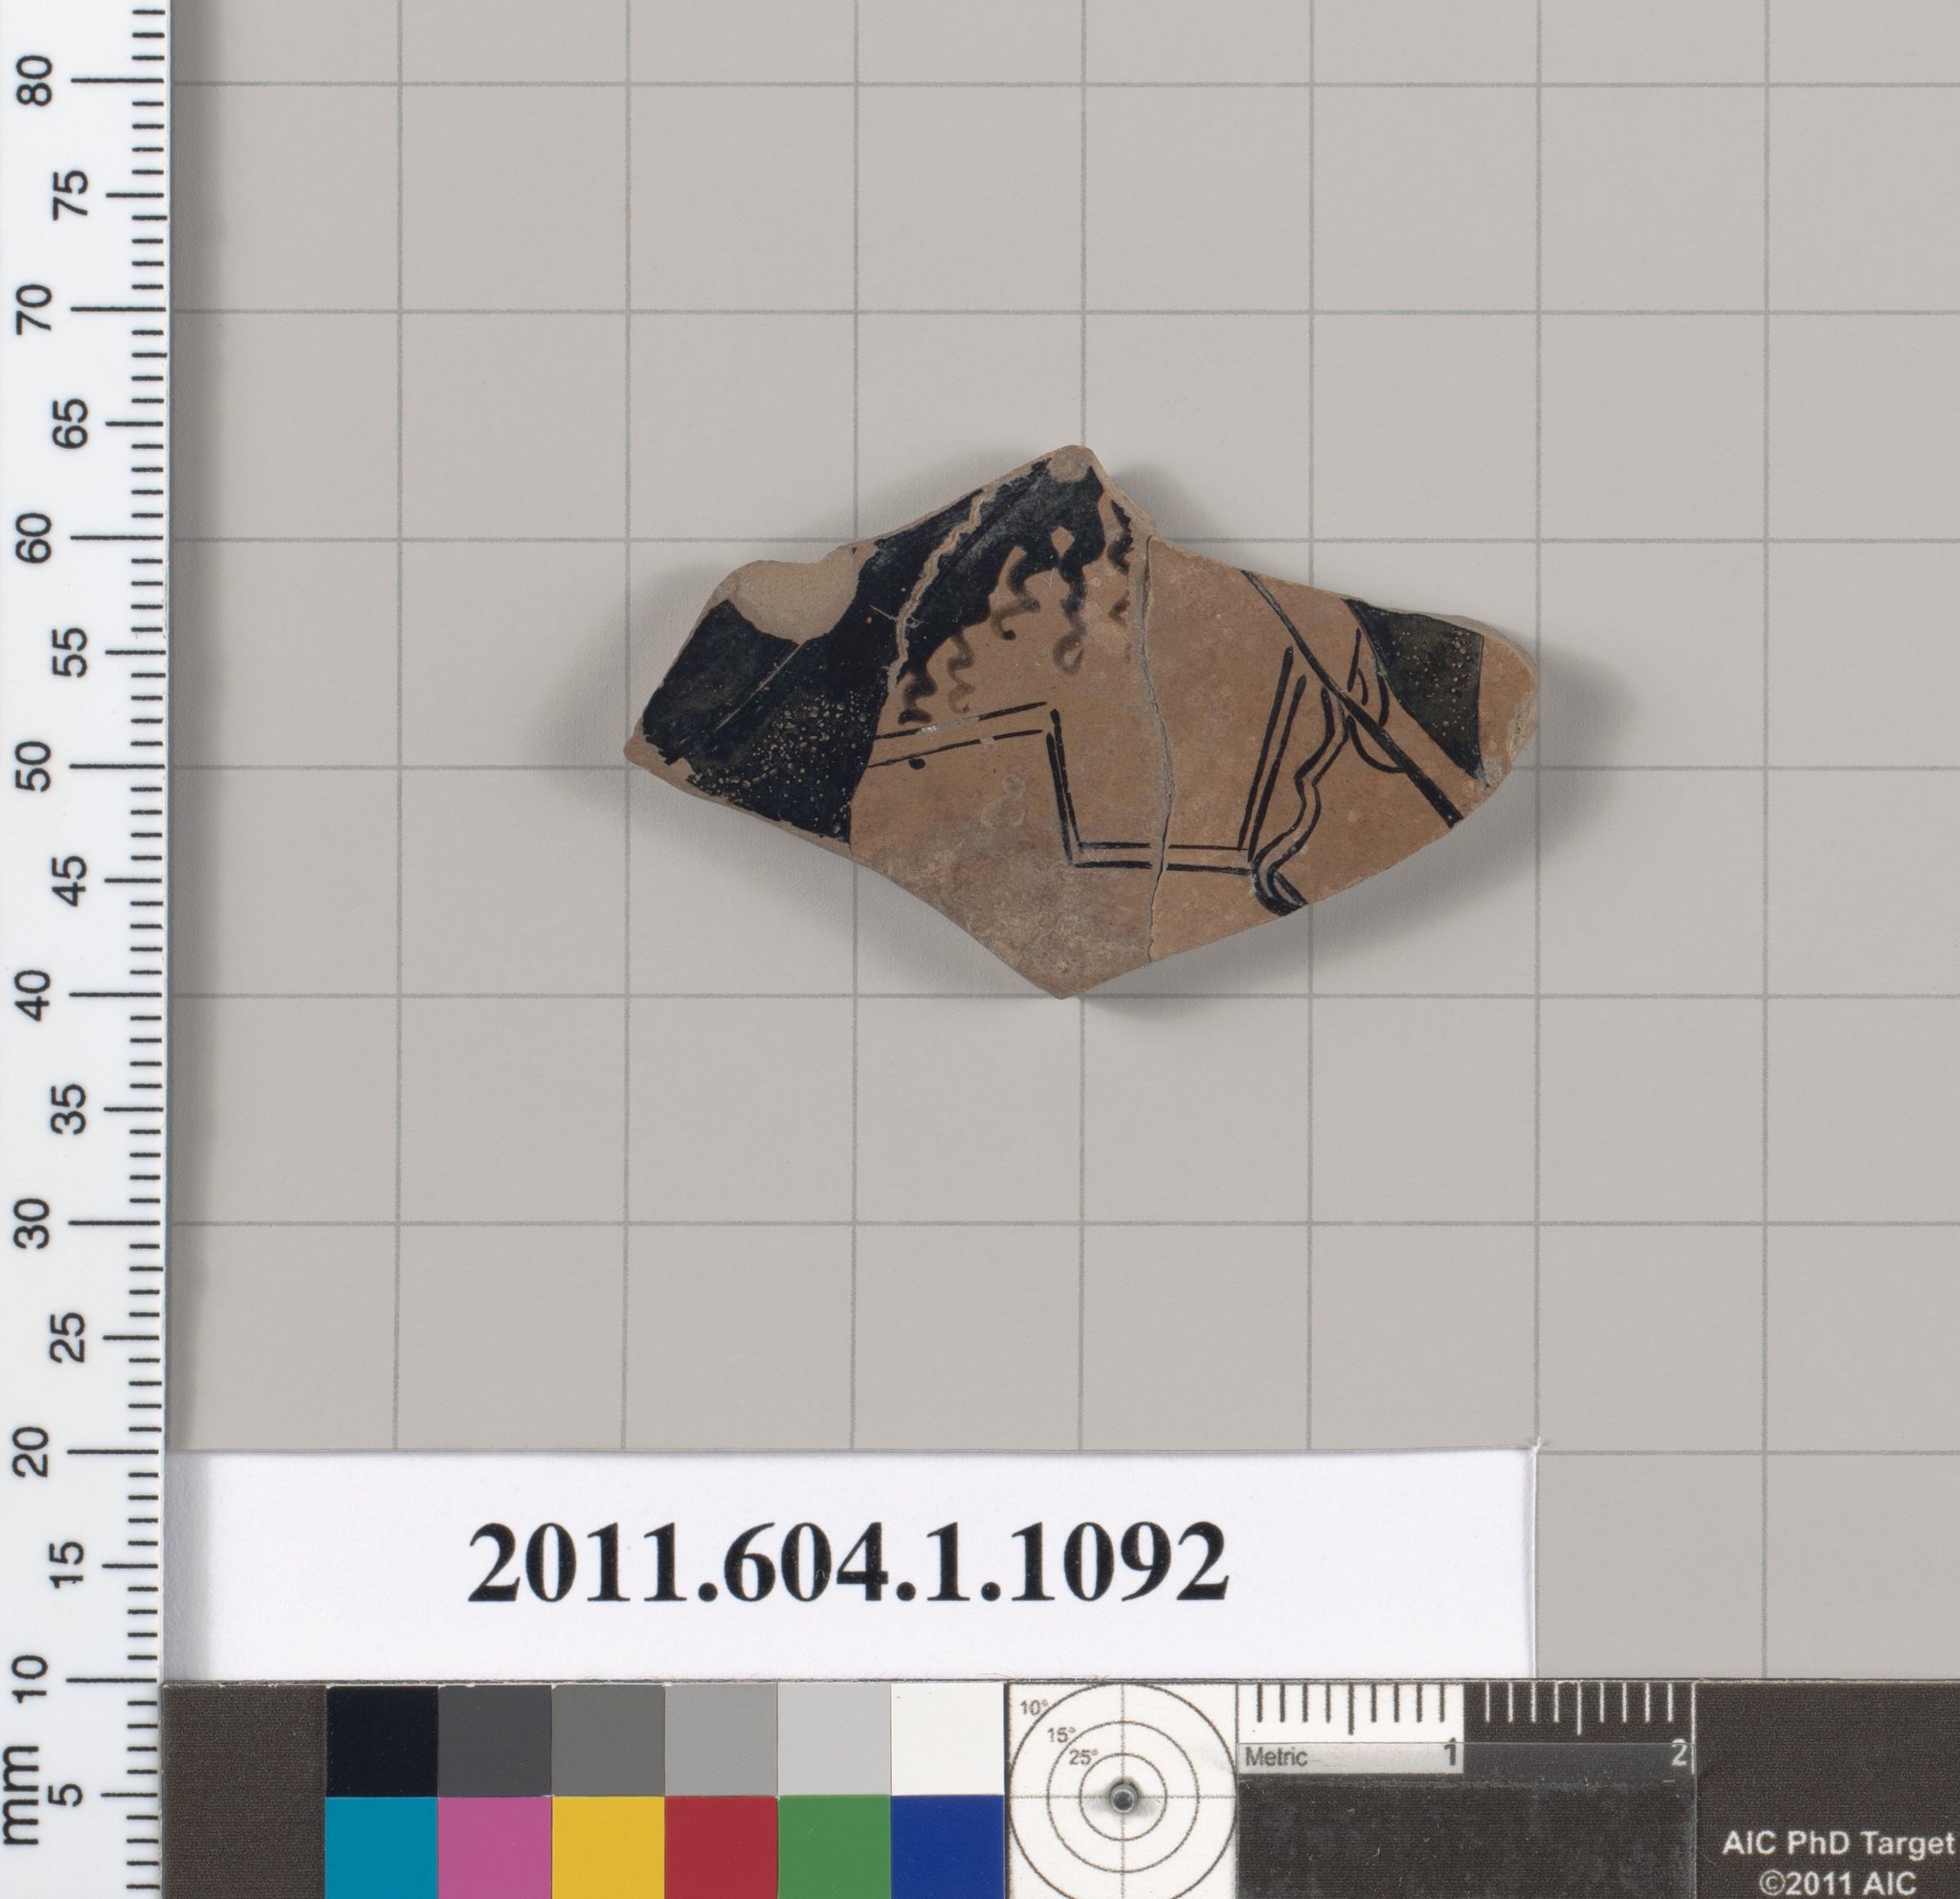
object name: kylix fragment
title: Terracotta fragment of a kylix (drinking cup)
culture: greek, attic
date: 475-451 BCE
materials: terracotta